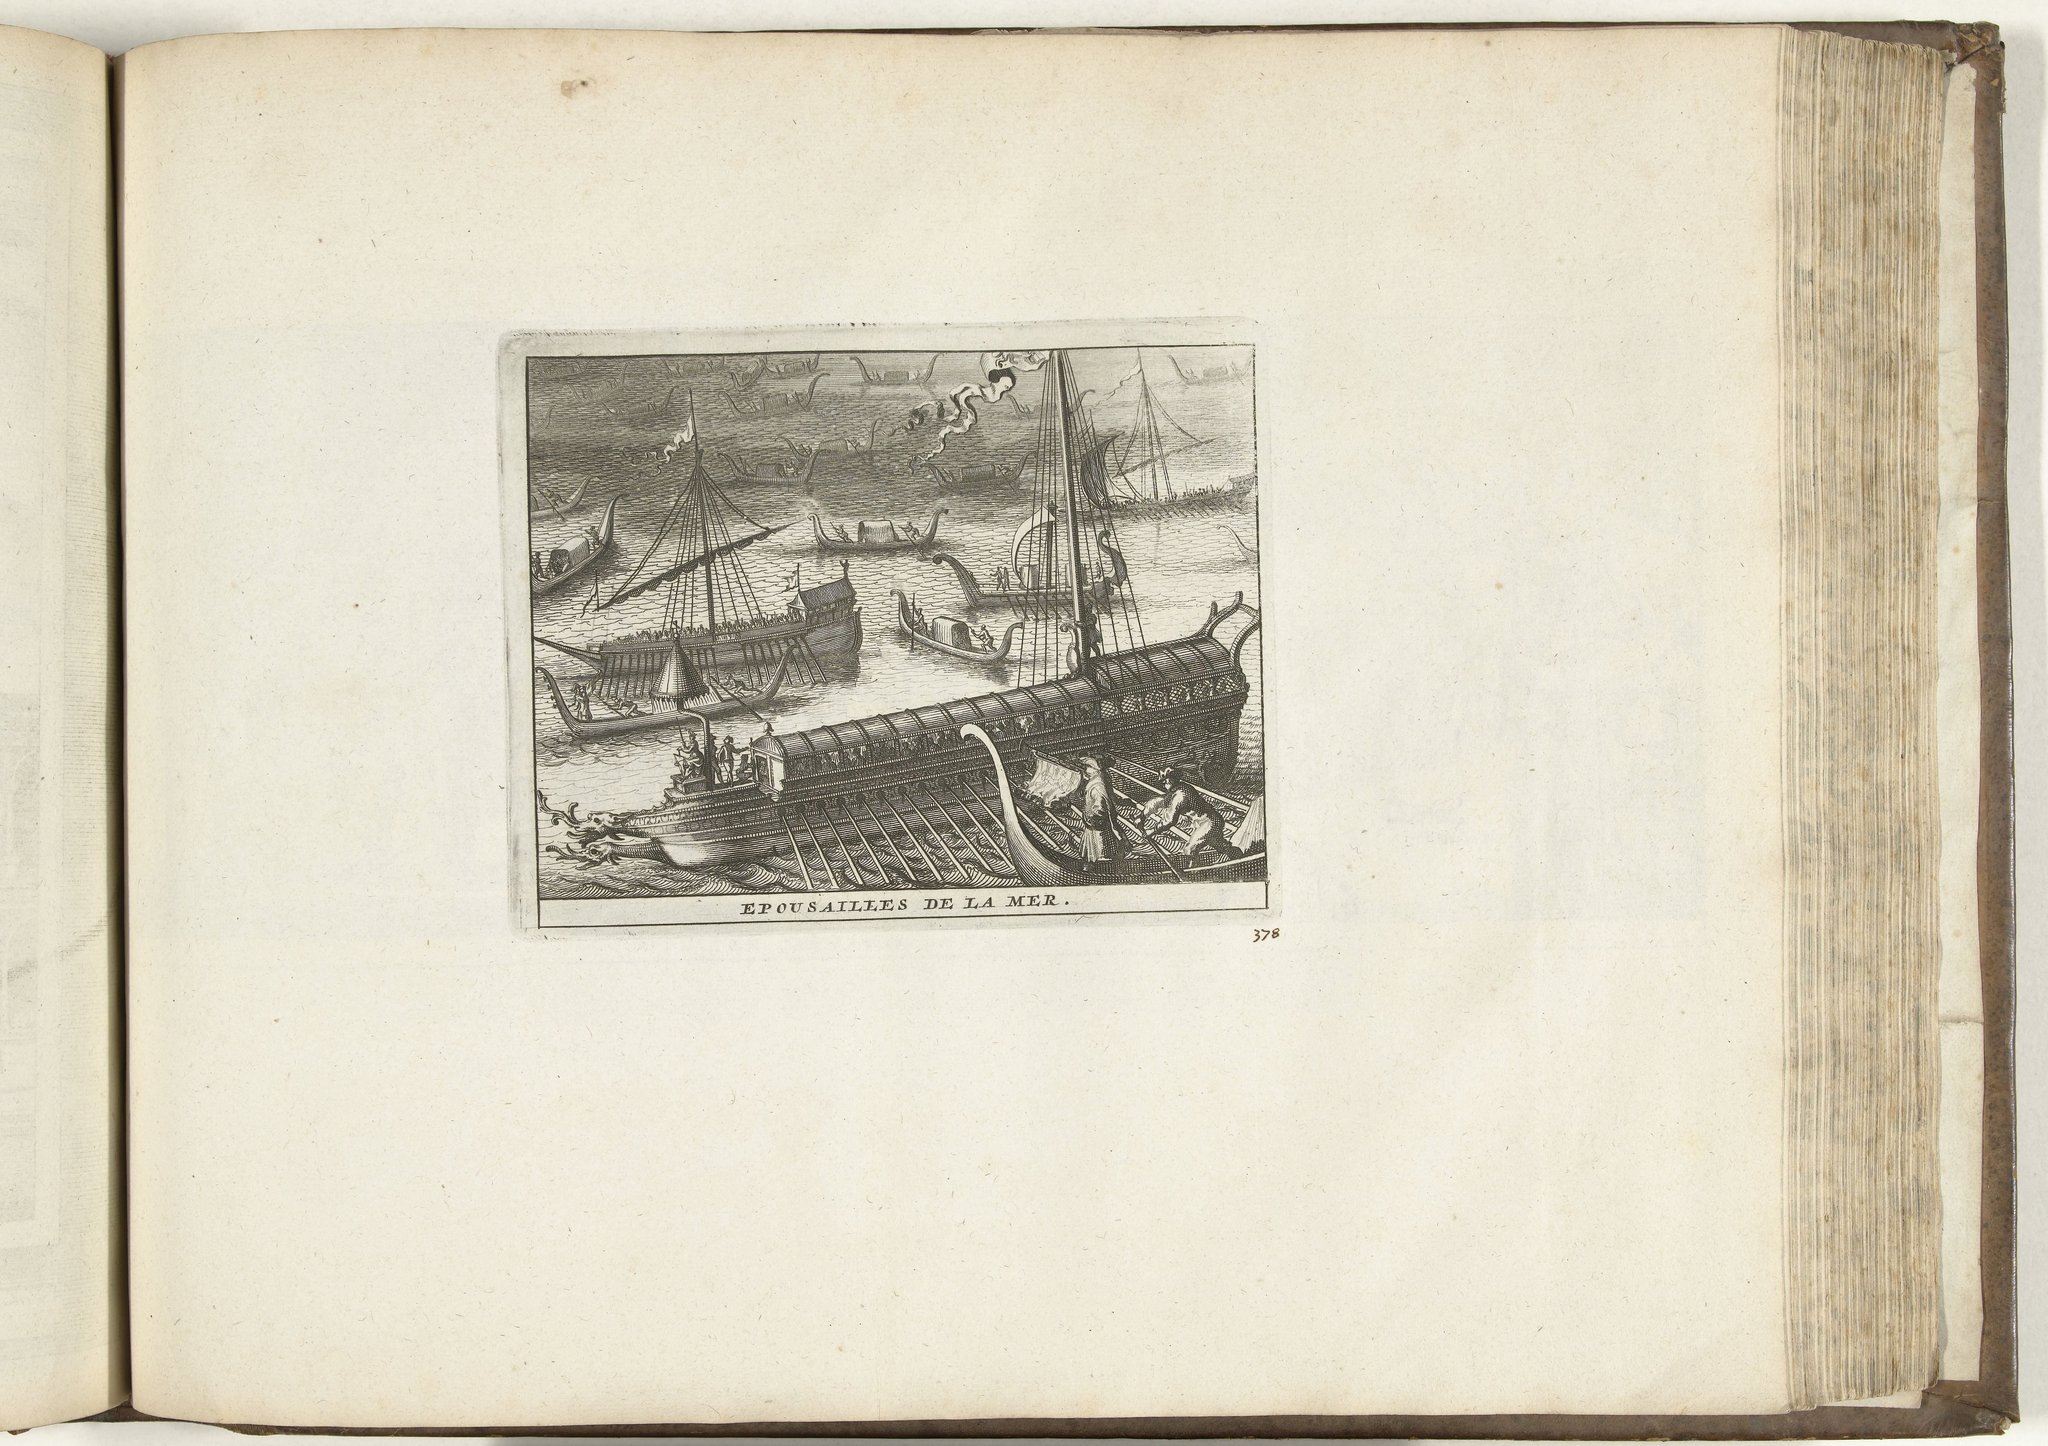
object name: print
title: Trouwfeest op het water te Venetië, 1726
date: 1726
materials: paper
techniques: etching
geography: leiden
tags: wedding feast, wedding meal, venice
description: Trouwfeest gevierd op het water te Venetië. Plaat nr. 378 in deel XVI van het prentwerk: Les Forces de l'Europe, Asie, Afrique et Amerique ... Comme aussi les Cartes des Côtes de France et d'Espagne uit 1726, dit tweede deel met 271 met de hand genummerde platen van vermaarde sterke steden en vestingen in het kader van de Spaanse Successieoorlog 1701-1713. Voor het merendeel zijn deze platen gekopieerd naar de anonieme Franse platen van vermaarde sterke steden en vestingen: in Les forces de l'Europe en in: Le theatre de la guerre, dans les Pays-Bas, beide oorspronkelijk uitgegeven door Nicolas de Fer te Parijs (1693-1697) in het kader van de Negenjarige Oorlog.